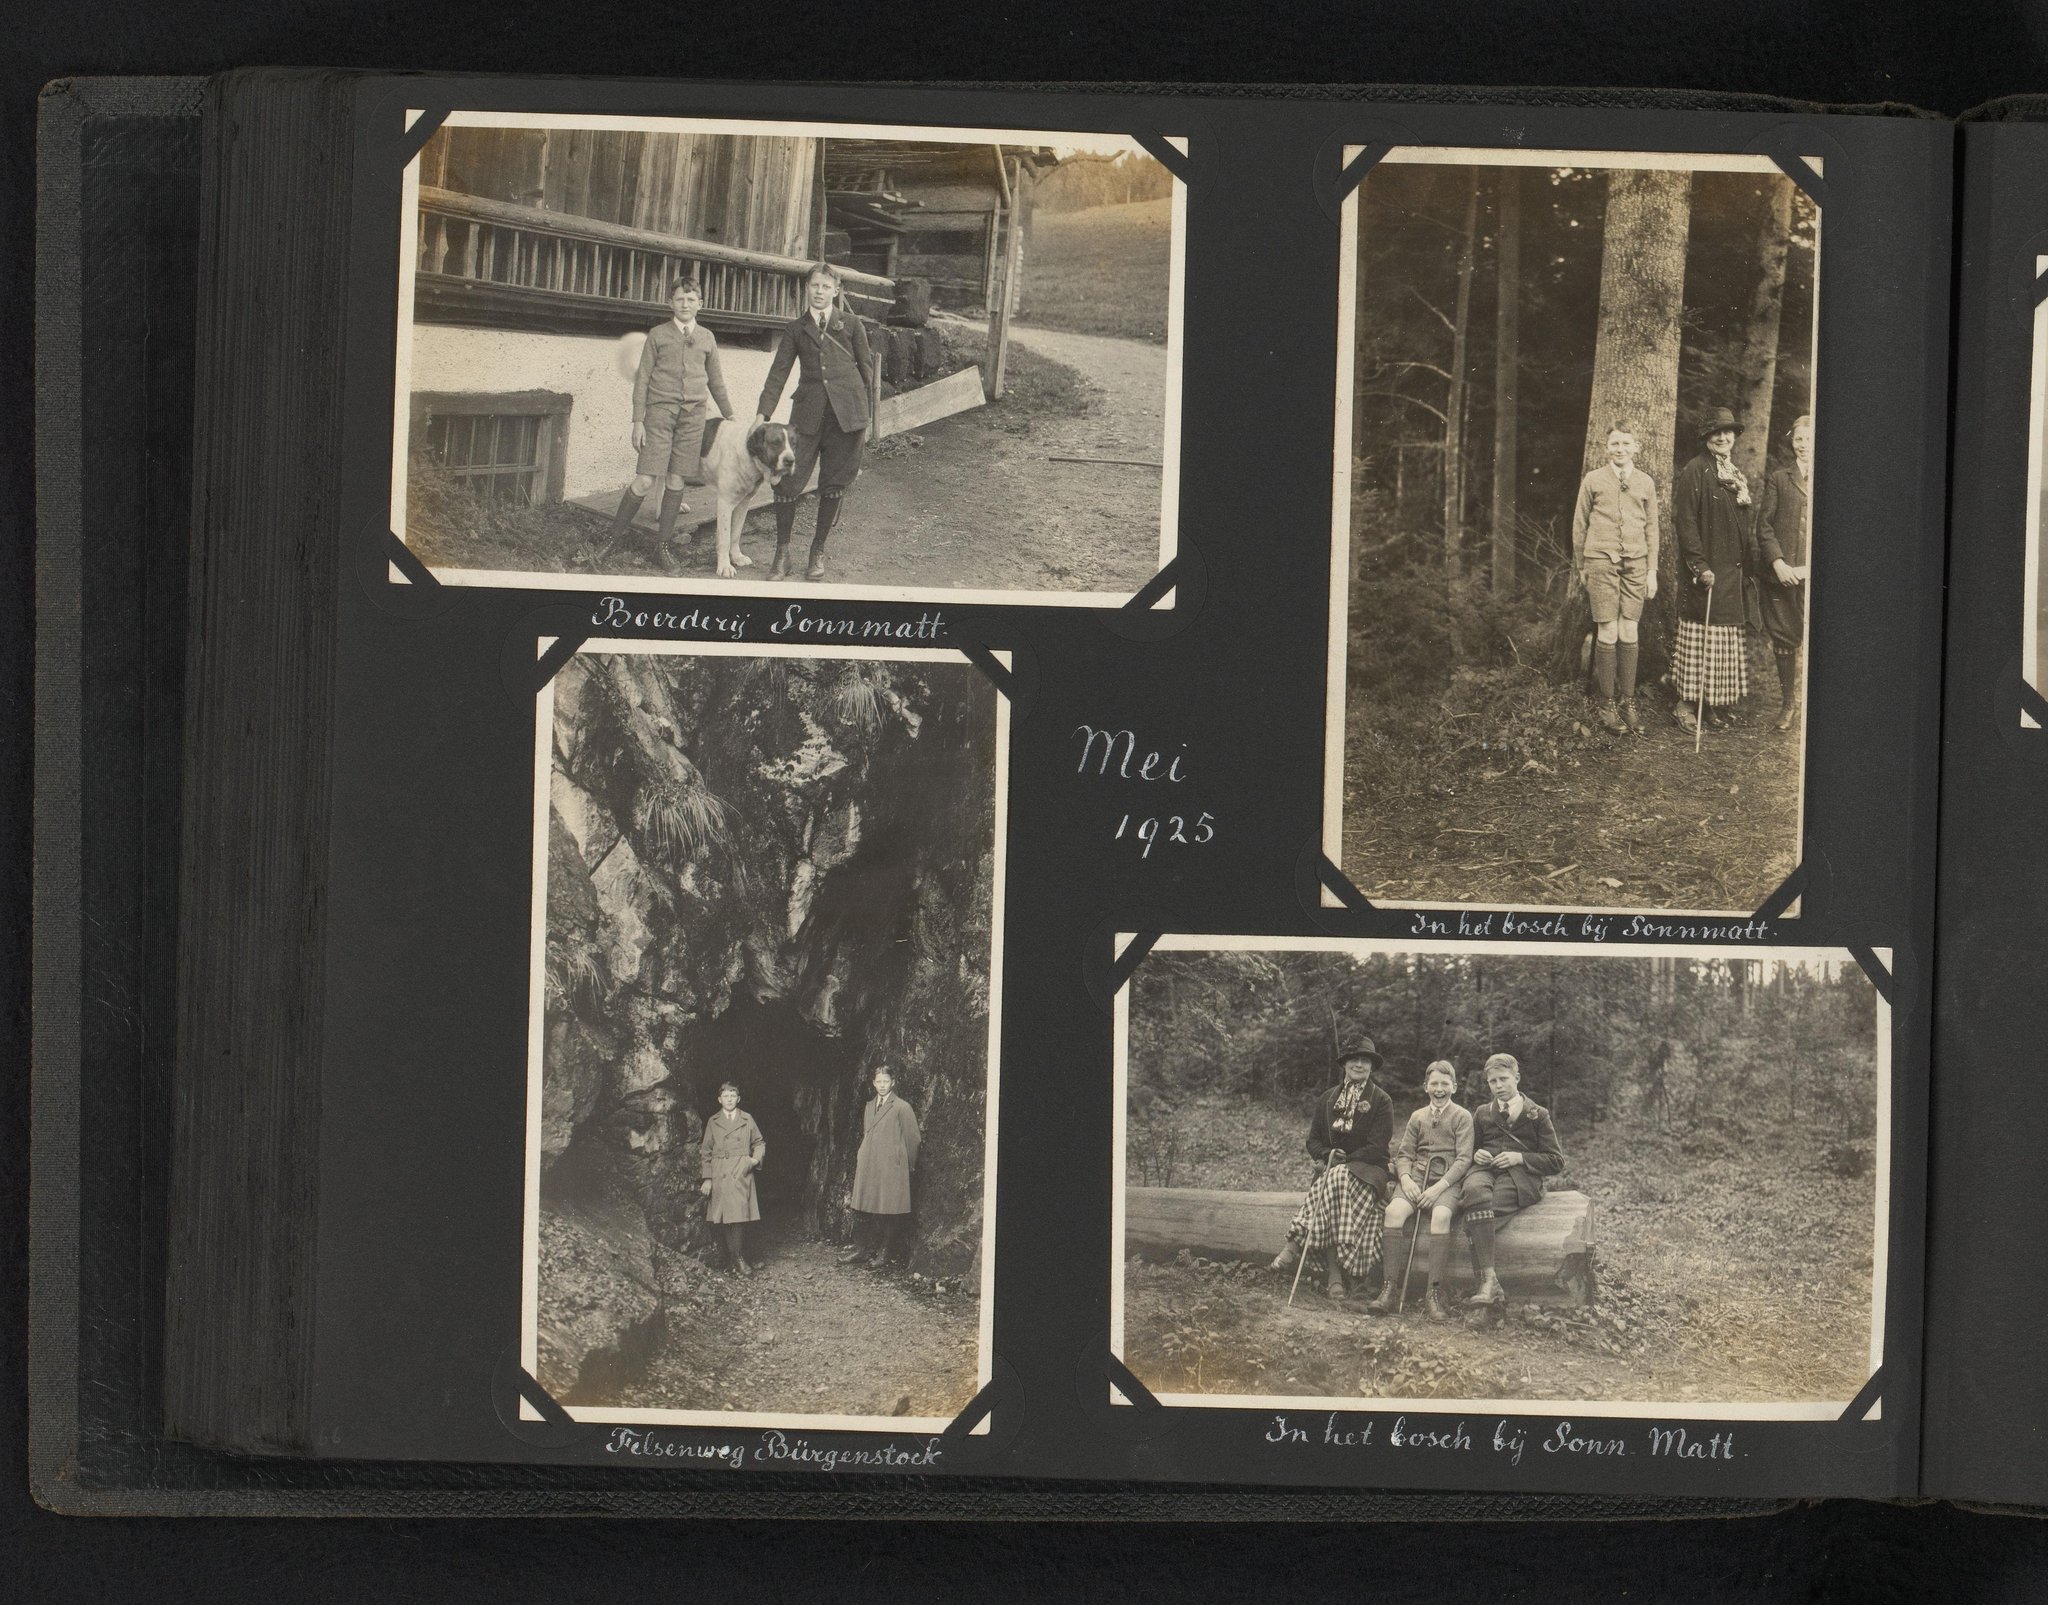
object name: album leaf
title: Mei 1925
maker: hendrik herman van den berg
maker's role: amateurfotograaf, jurist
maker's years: 1875-1944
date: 1905-1925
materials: paper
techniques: gelatin silver print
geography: switzerland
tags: the hague, caroline louise van den berg-van den berg, amsterdam, carel frederik van den berg (cay), frank willem van den berg (1912-1998), the family travelling, on holiday, switzerland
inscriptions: inscription: ‘In het bosch bij Sonnmatt’, inscription: ‘In het bosch bij Sonn Matt’, inscription: ‘Boerderij Sonnmatt’, inscription: ‘Felsenweg Bürgenstock’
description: Deze foto's maken deel uit van een album.